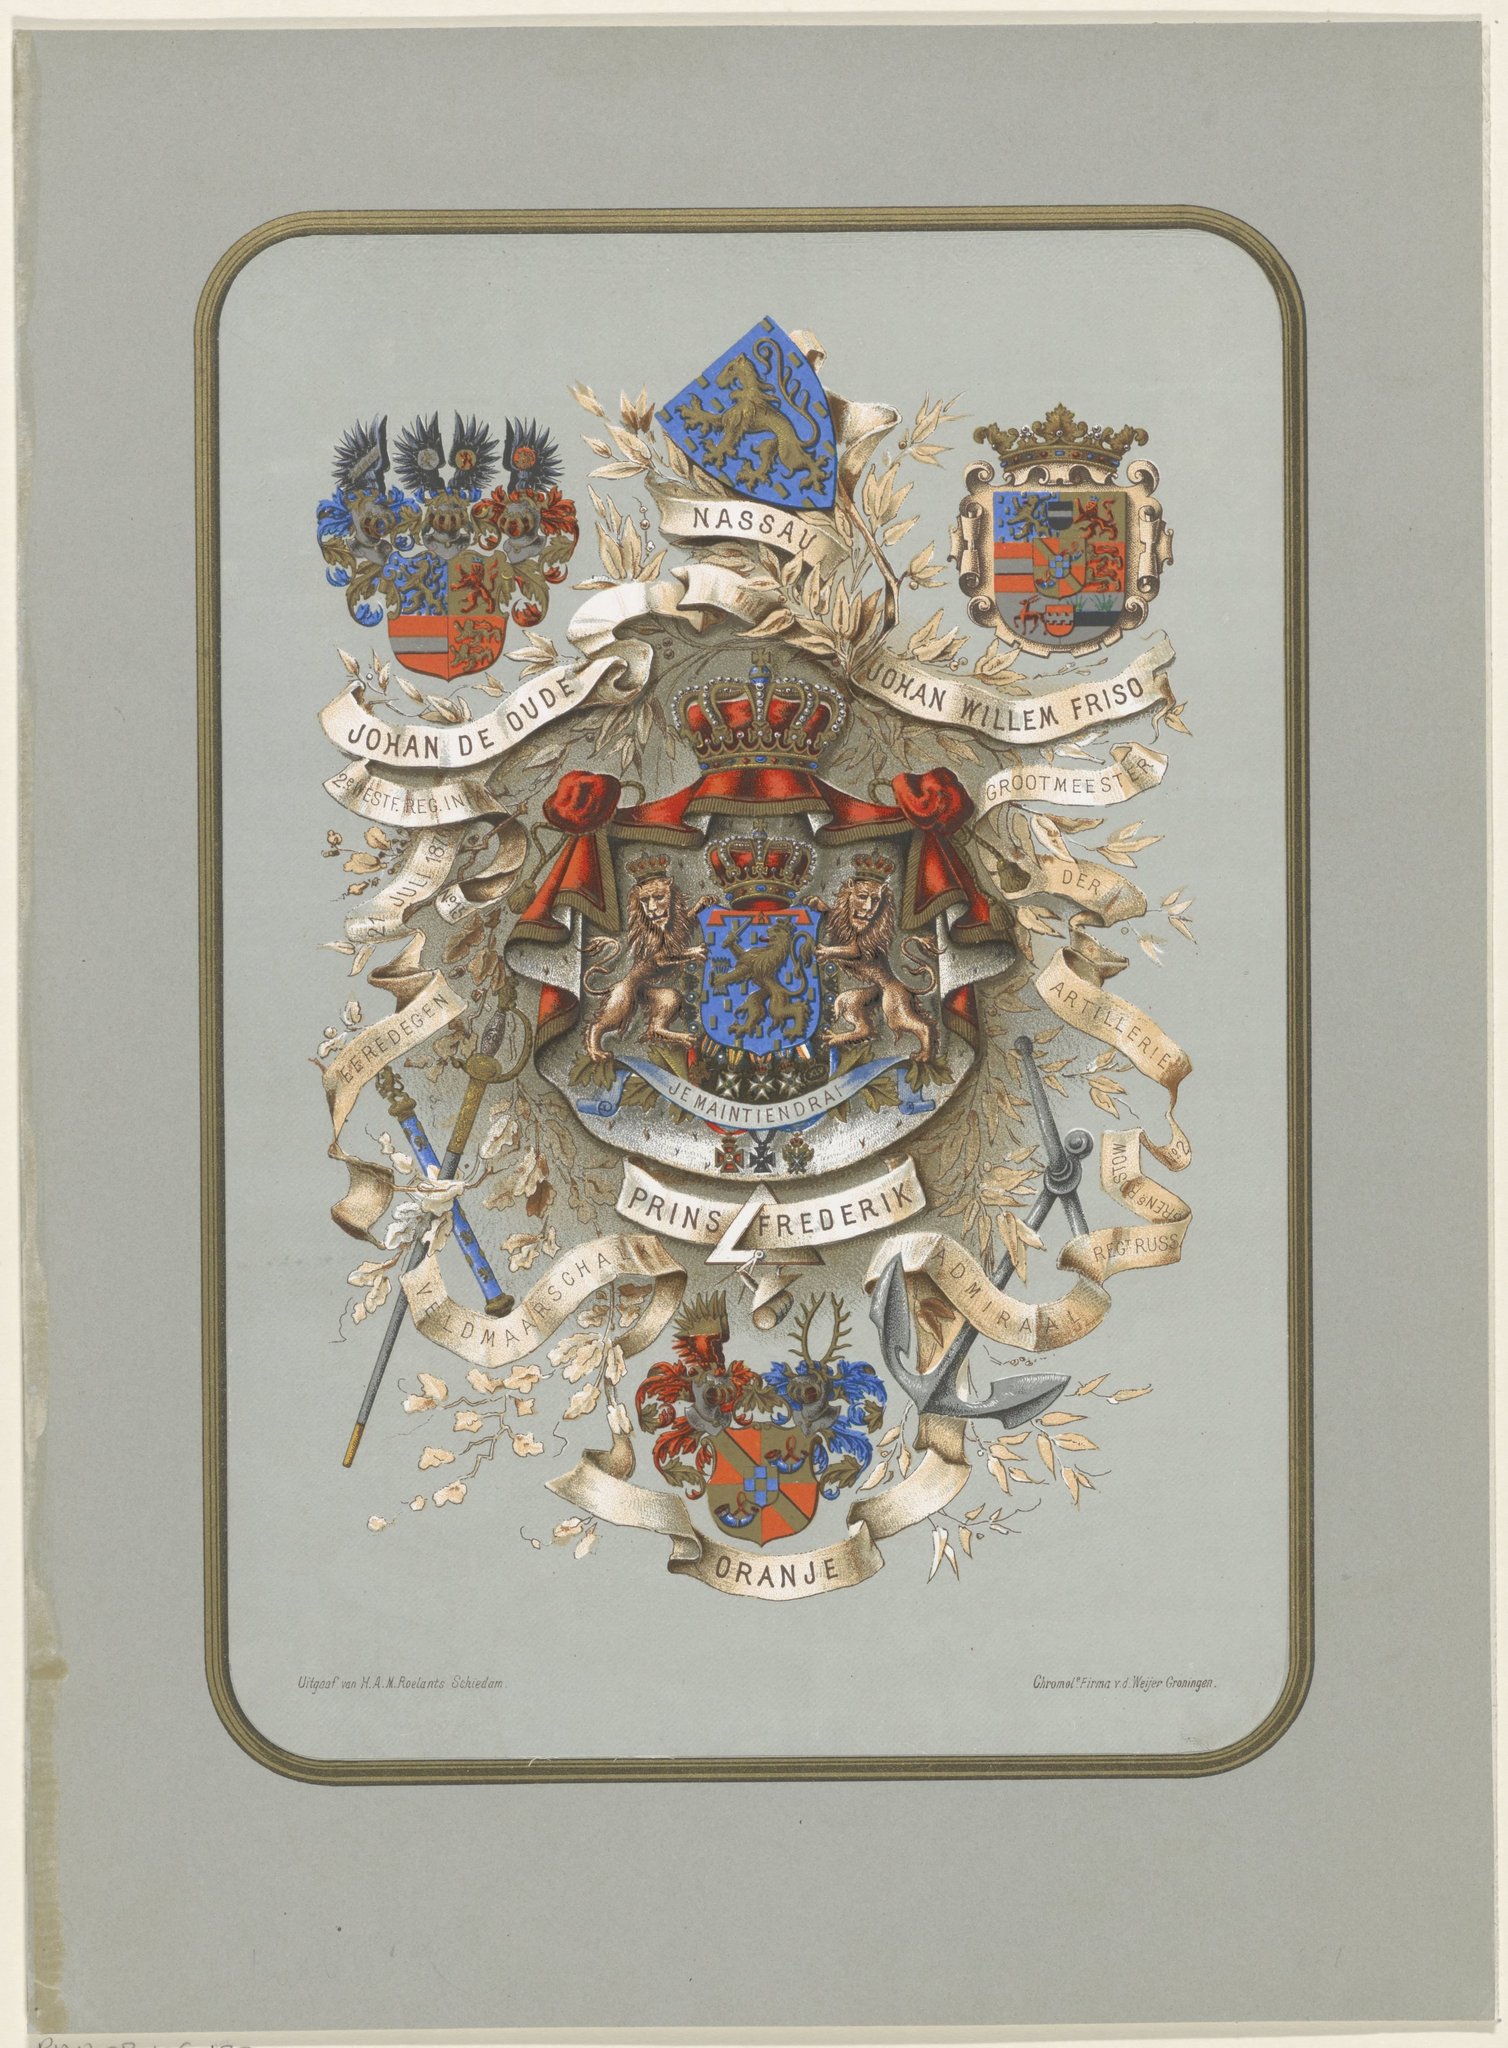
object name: print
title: Wapen van Frederik, prins der Nederlanden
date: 1876-1907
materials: cardboard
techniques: chromolithography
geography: groningen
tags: johan willem friso (prins van oranje-nassau), berlin, frederik (prins der nederlanden)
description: Wapen van Frederik met een kroon en twee leeuwen. Daaronder op een banderol zijn geslachtsspreuk. Daar omheen een aantal wapens, waaronder de wapens van Johan VI en Johan Willem Friso. Op banderollen hun namen en regels Nederlandse tekst.